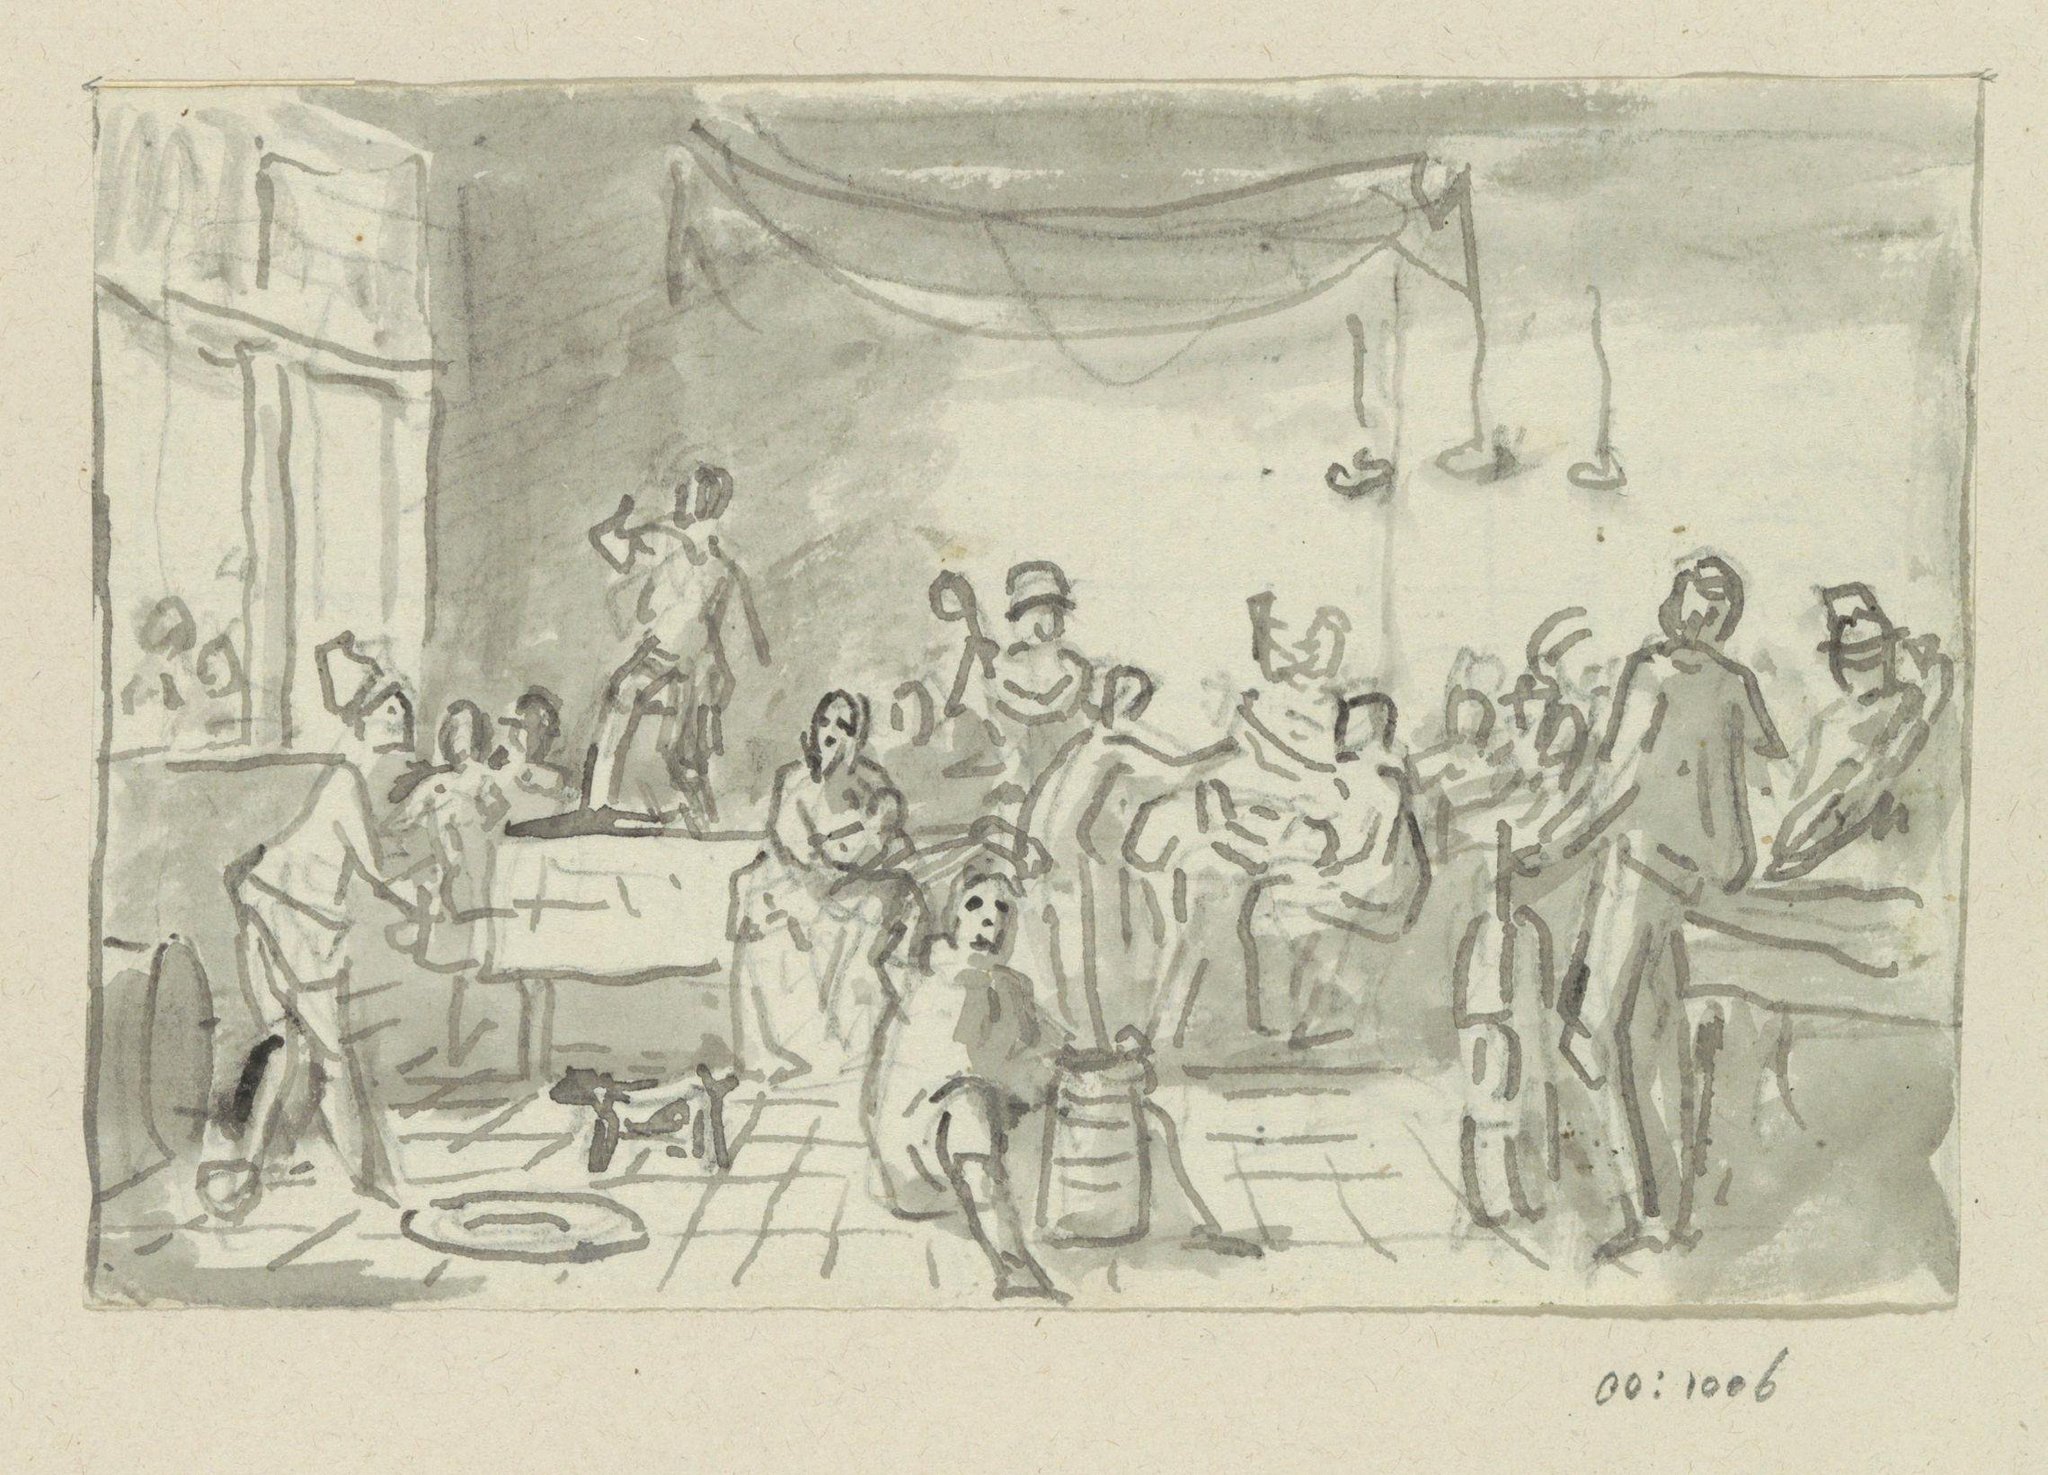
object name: drawing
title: Gezelschap in een kamer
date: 1800-1819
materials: paper, pencil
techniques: brush, pen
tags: loose company